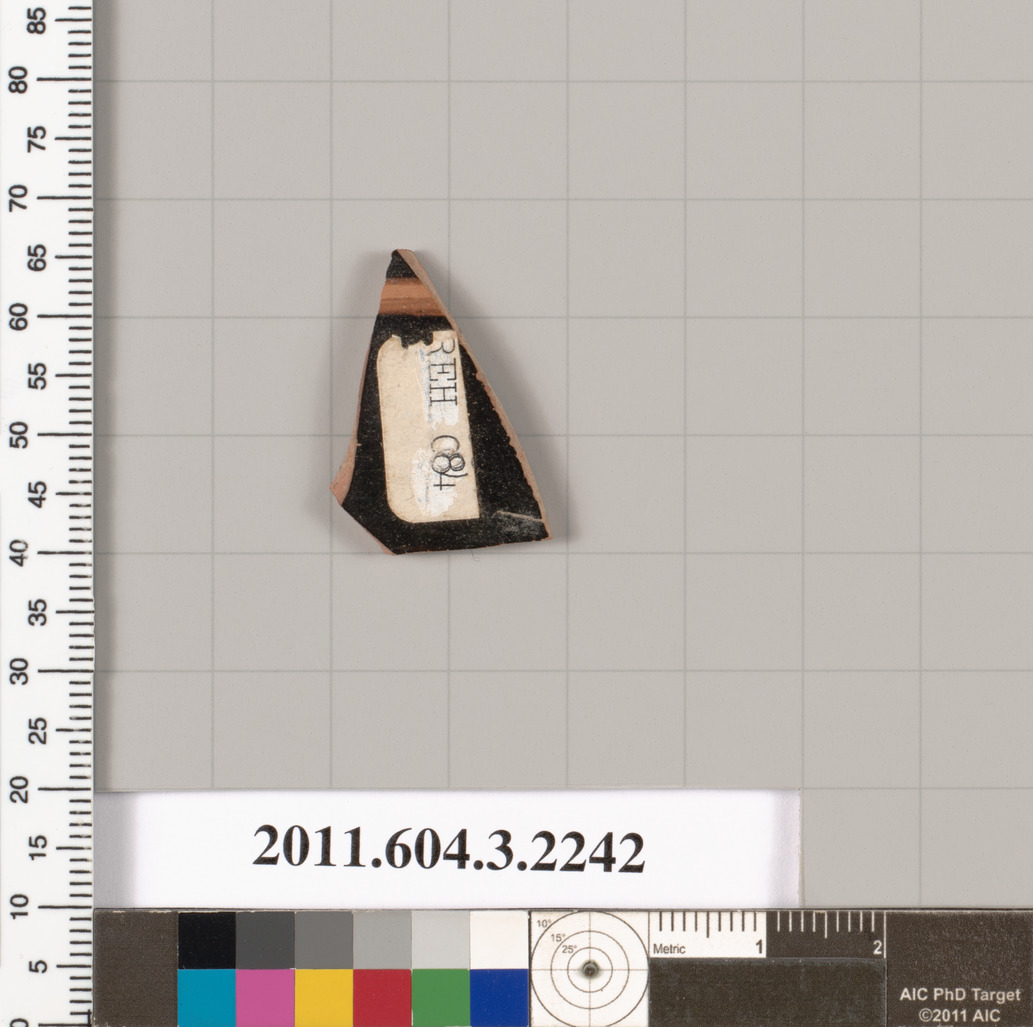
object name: kylix fragment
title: Terracotta fragment of a kylix (drinking cup)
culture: greek, attic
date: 600-401 BCE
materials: terracotta